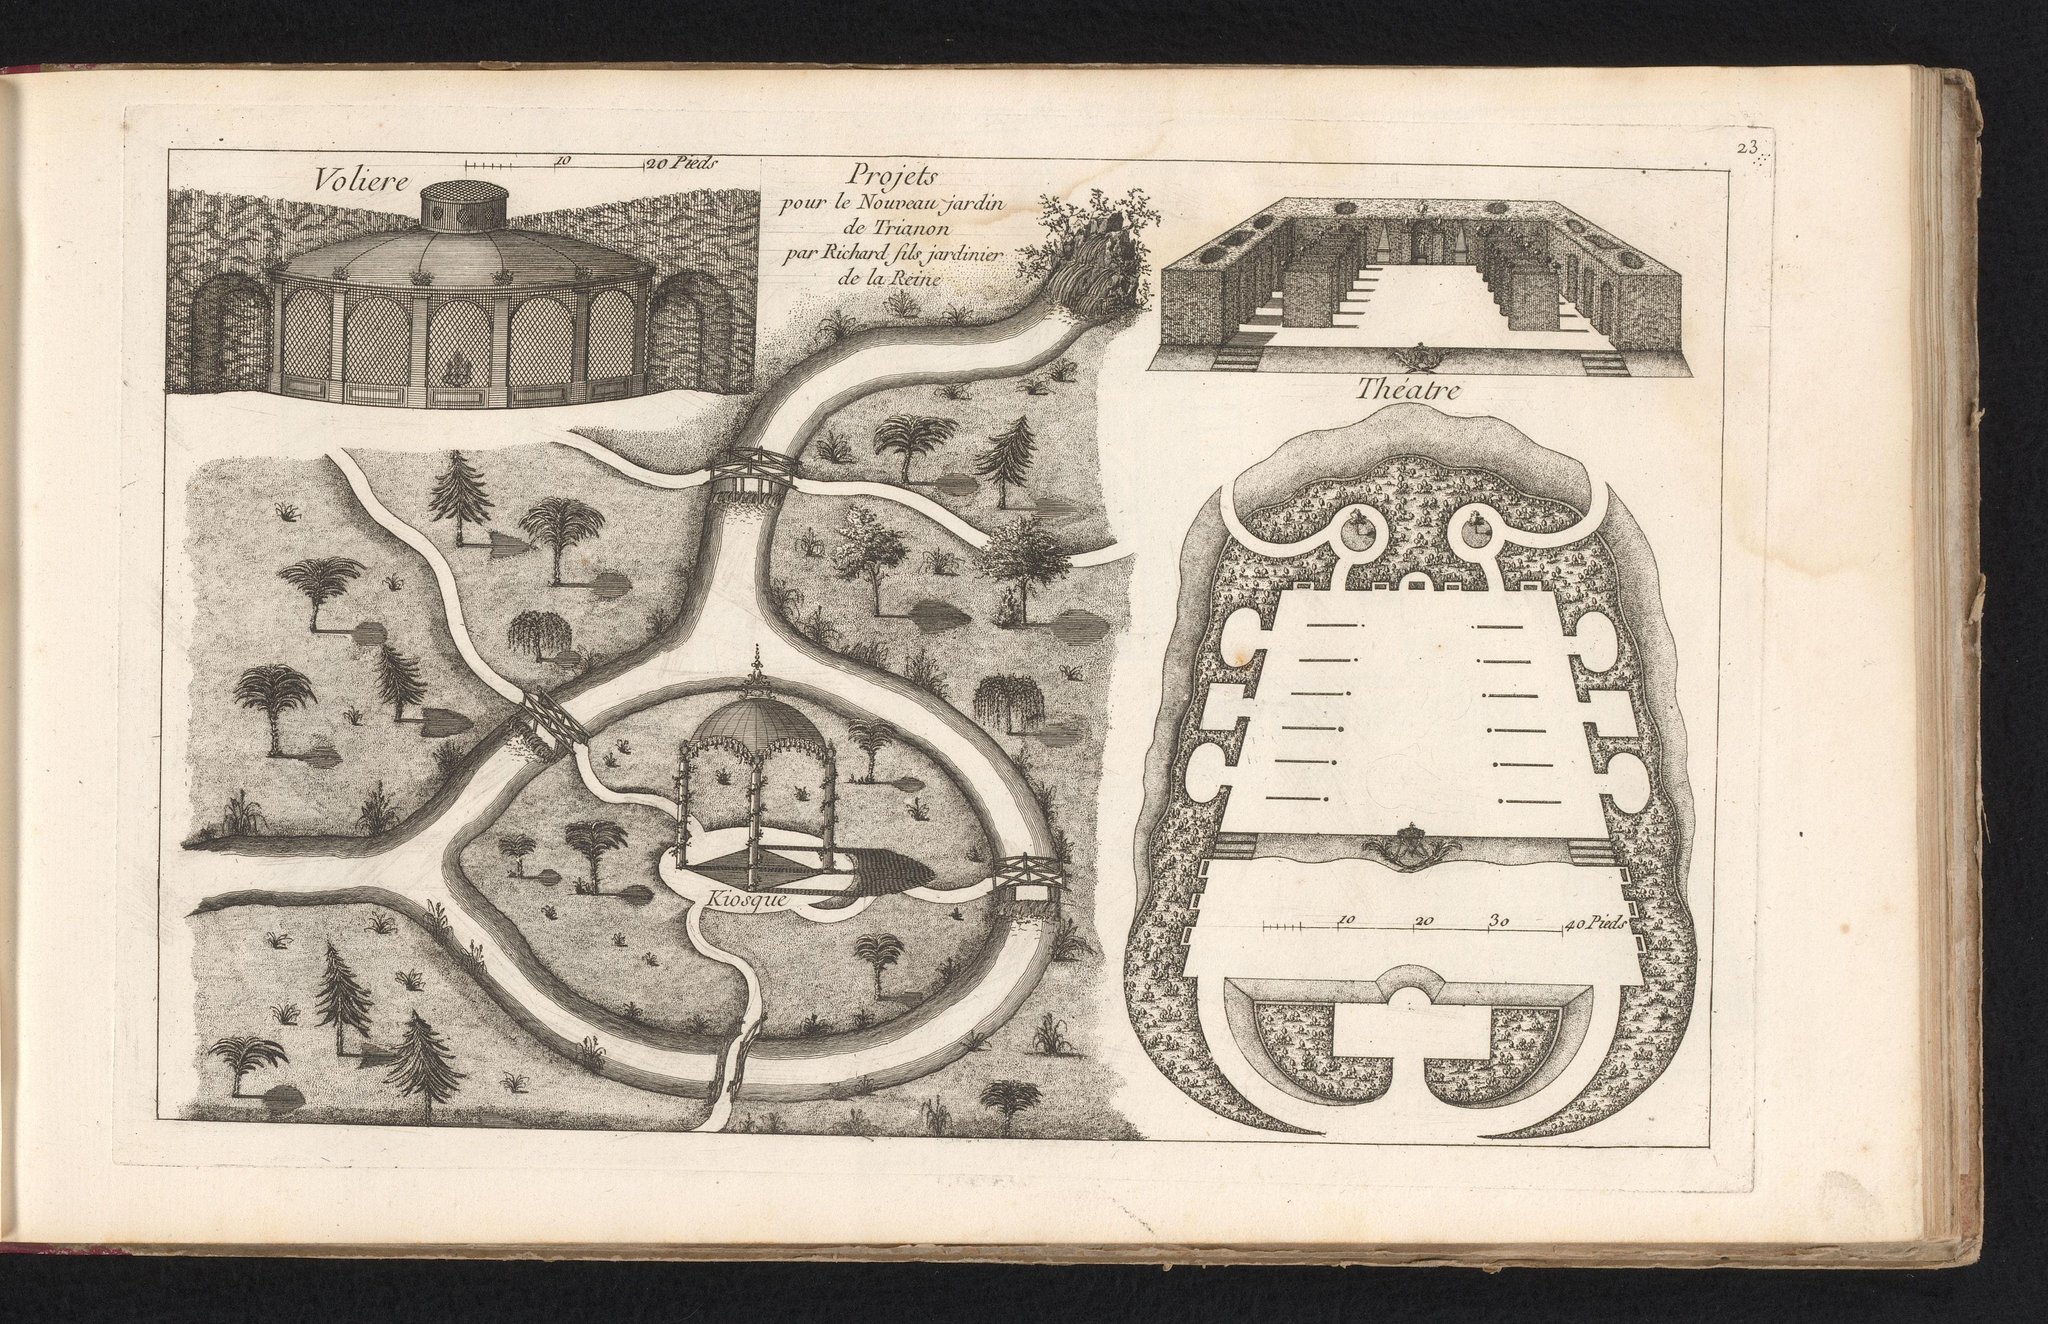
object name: album leaf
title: Landschapstuinen in Chinees-Engelse stijl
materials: paper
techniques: engraving, etching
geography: paris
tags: plan, map of garden, garden buildings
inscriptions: collector's mark: Lugt 2228, collector's mark: Lugt 2760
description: De serie 'Jardins anglo-chinois à la mode' verscheen in totaal in 21 zogeheten 'cahiers' (afleveringen). De huidige prent komt uit het zesde 'cahier'. Het Rijksmuseum Amsterdam bezit drie banden met daarin in totaal zes 'cahiers' van deze reeks. In de documentatie wordt verwezen naar een in de bibliotheek van het Rijksmuseum Amsterdam aanwezige facsimile van het complete werk.